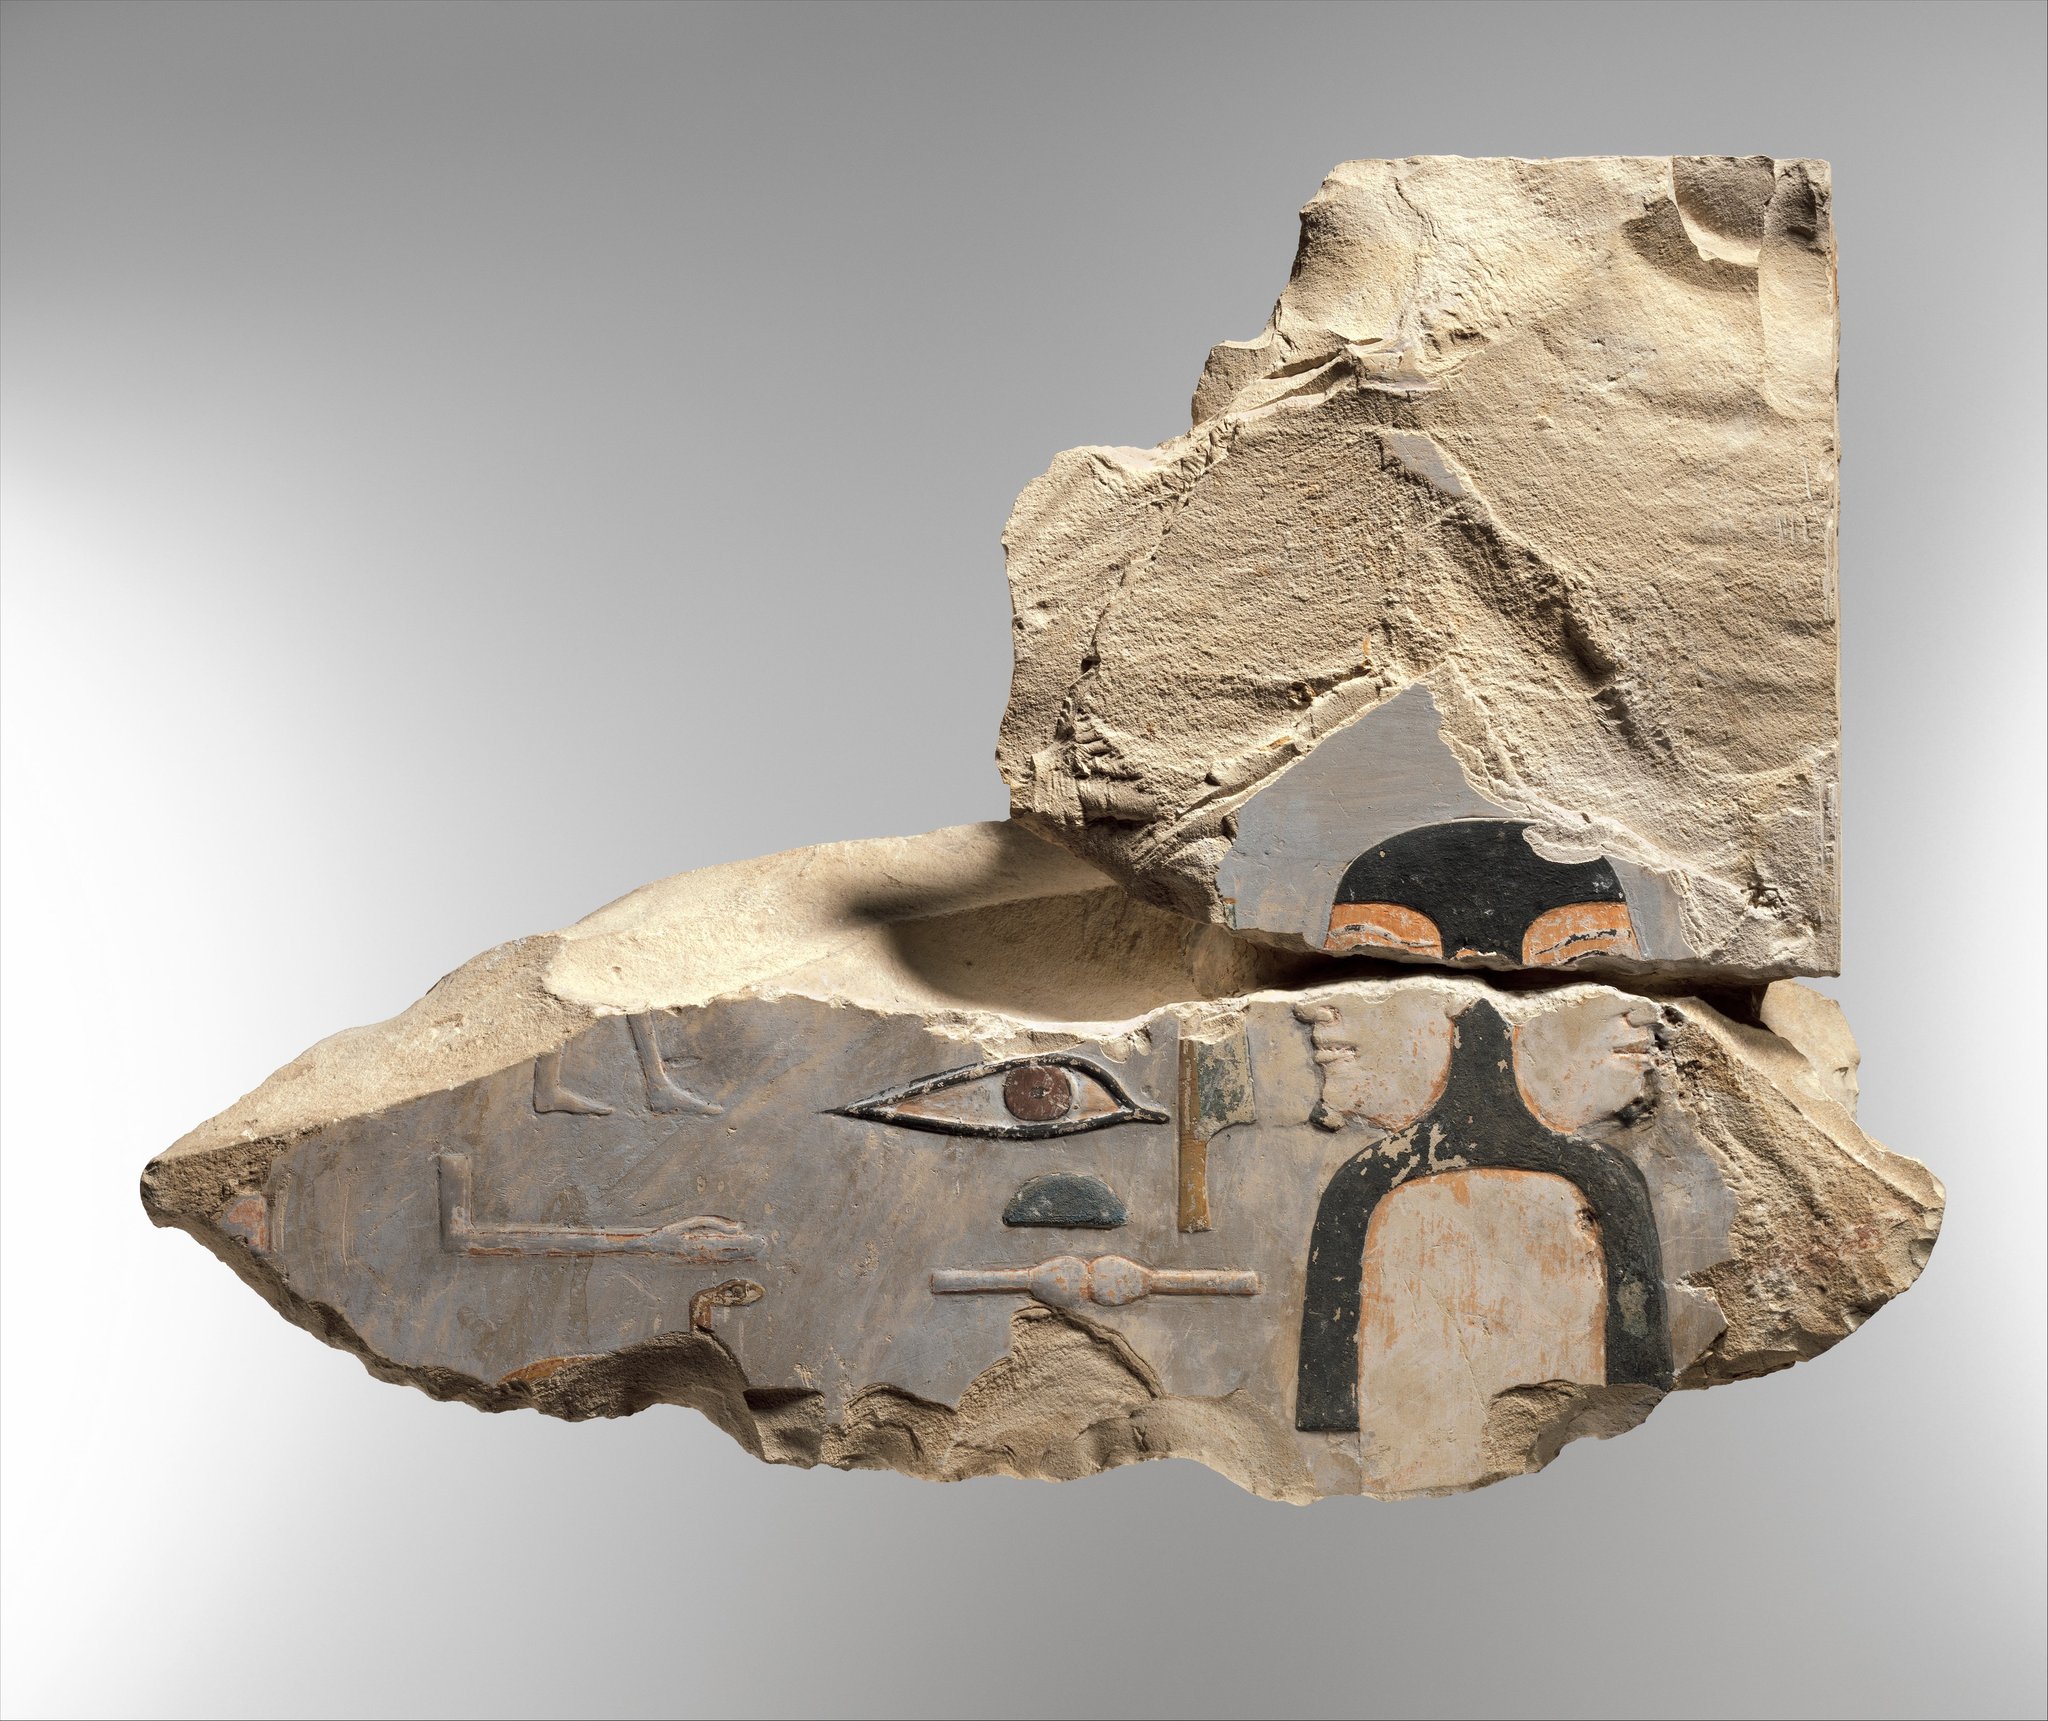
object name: relief fragment, tomb of meketre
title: Relief fragments from tomb of Meketre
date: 1981-1975 BCE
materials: limestone, paint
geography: egypt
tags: hieroglyphs